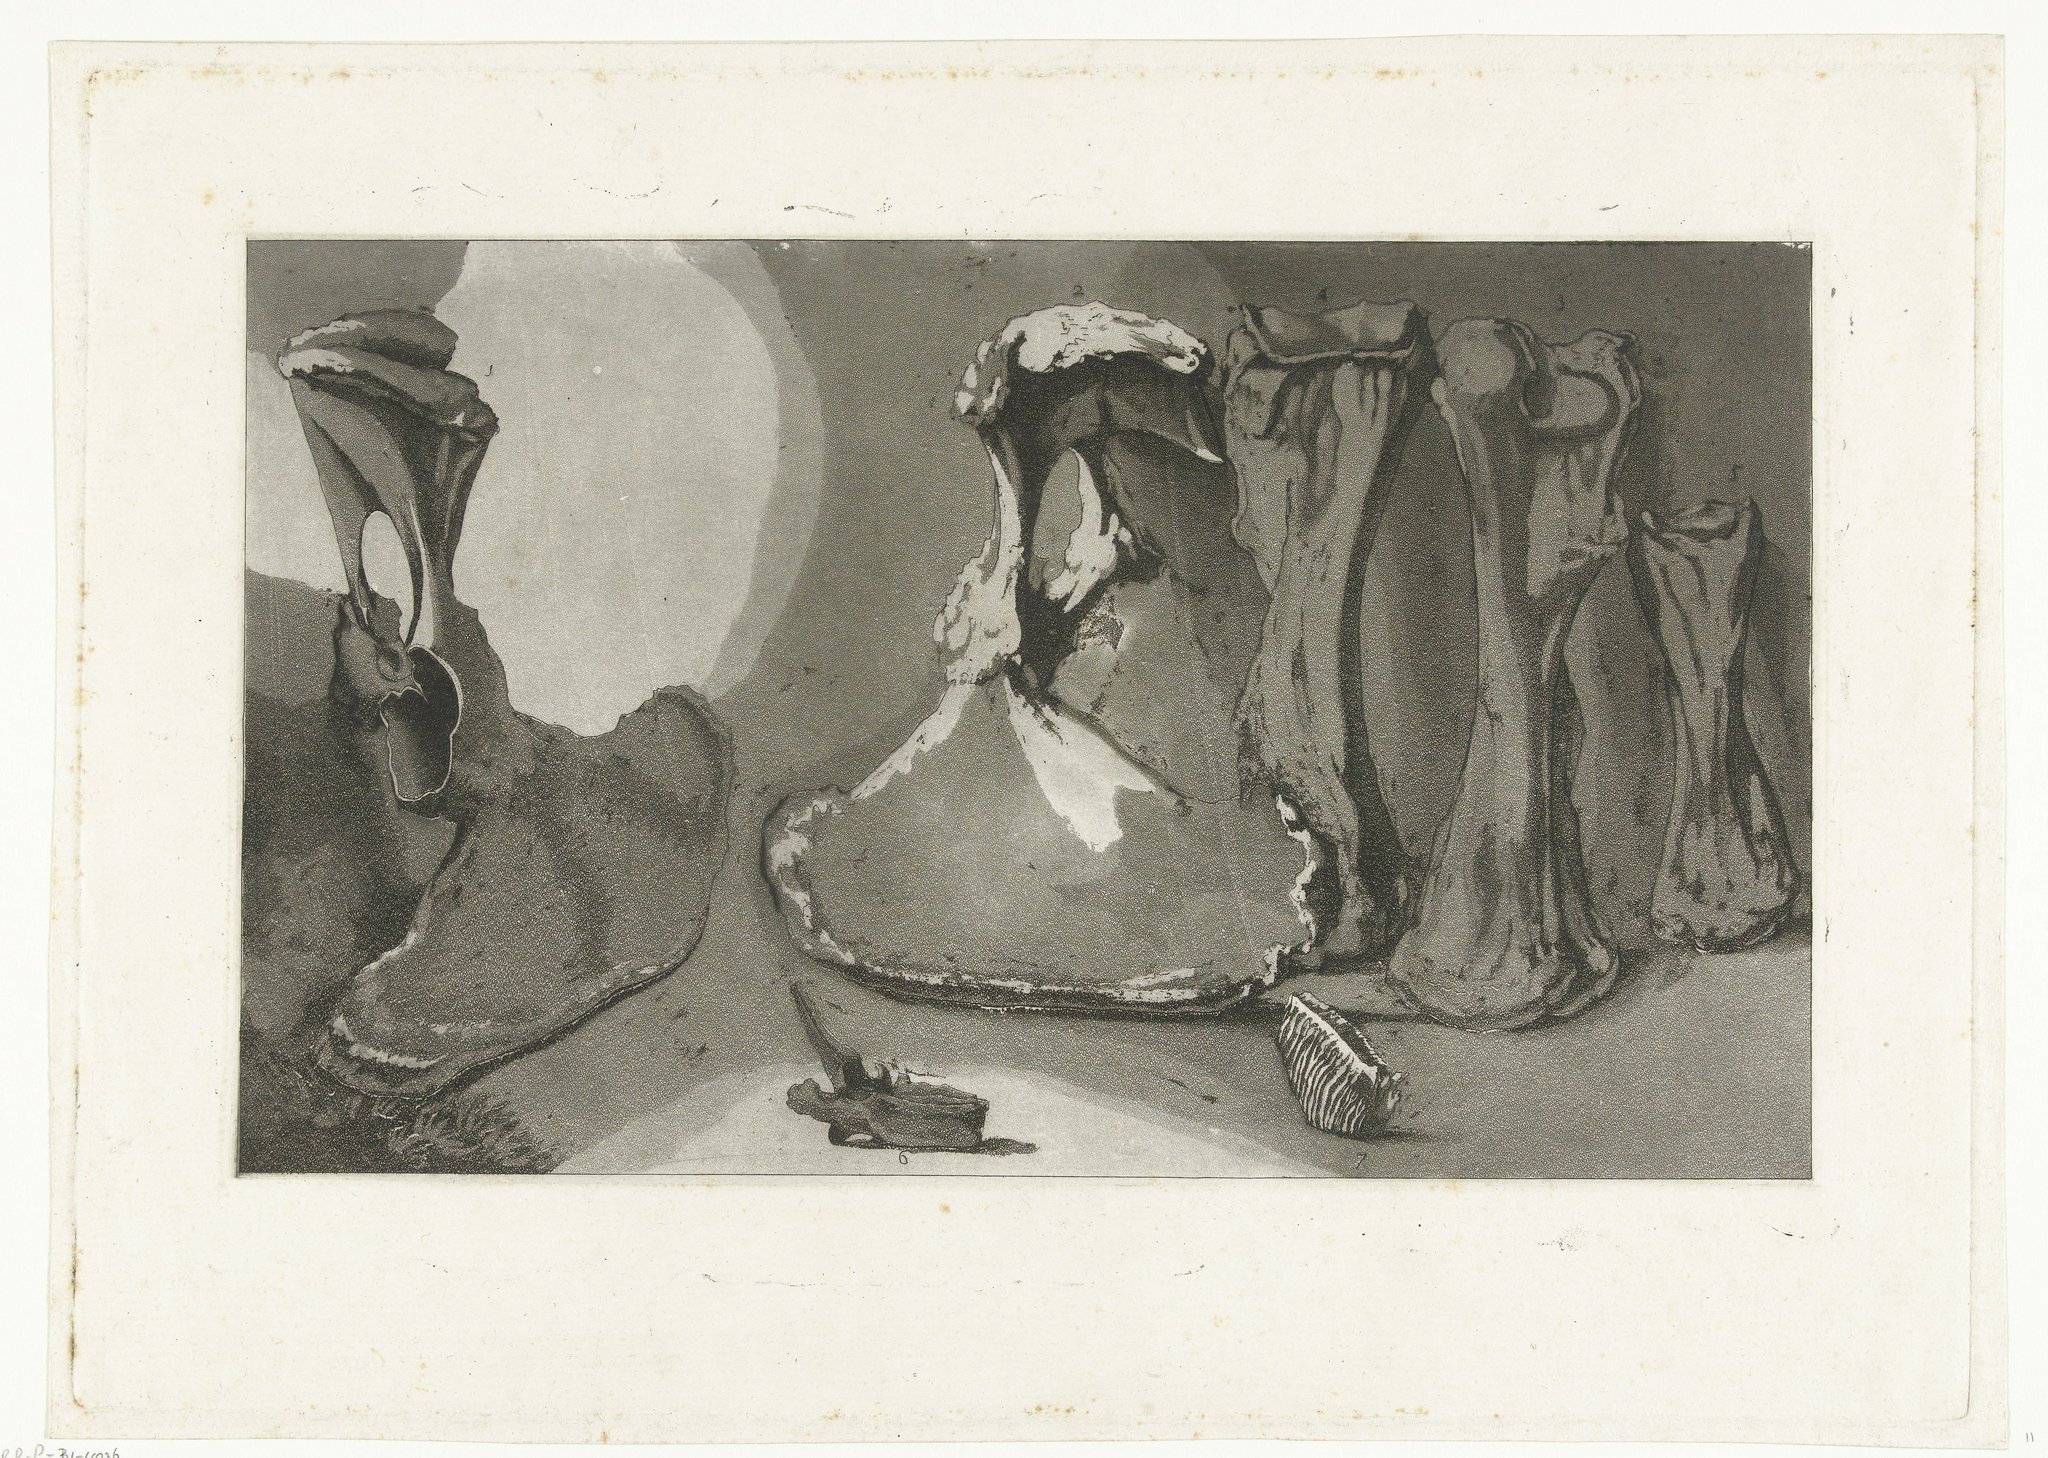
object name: print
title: Aangespoelde beenderen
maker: anthonie van den bos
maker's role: draughtsman, print maker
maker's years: 1763-1838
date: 1809-1810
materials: paper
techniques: aquatint, etching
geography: netherlands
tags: bones in general (human body), gelderland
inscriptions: collector's mark: Lugt 2228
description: Plaat gemaakt voor: H. Ewijk, Platen en kaarten behorende tot het geschiedkundig verslag der dijkbreuken en overstroomingen, langs de rivieren in het Koningrijk Holland, voorgevallen in louwmaand MDCCCIX. Amsterdam, J. Allart en J. Ruys, 1809.